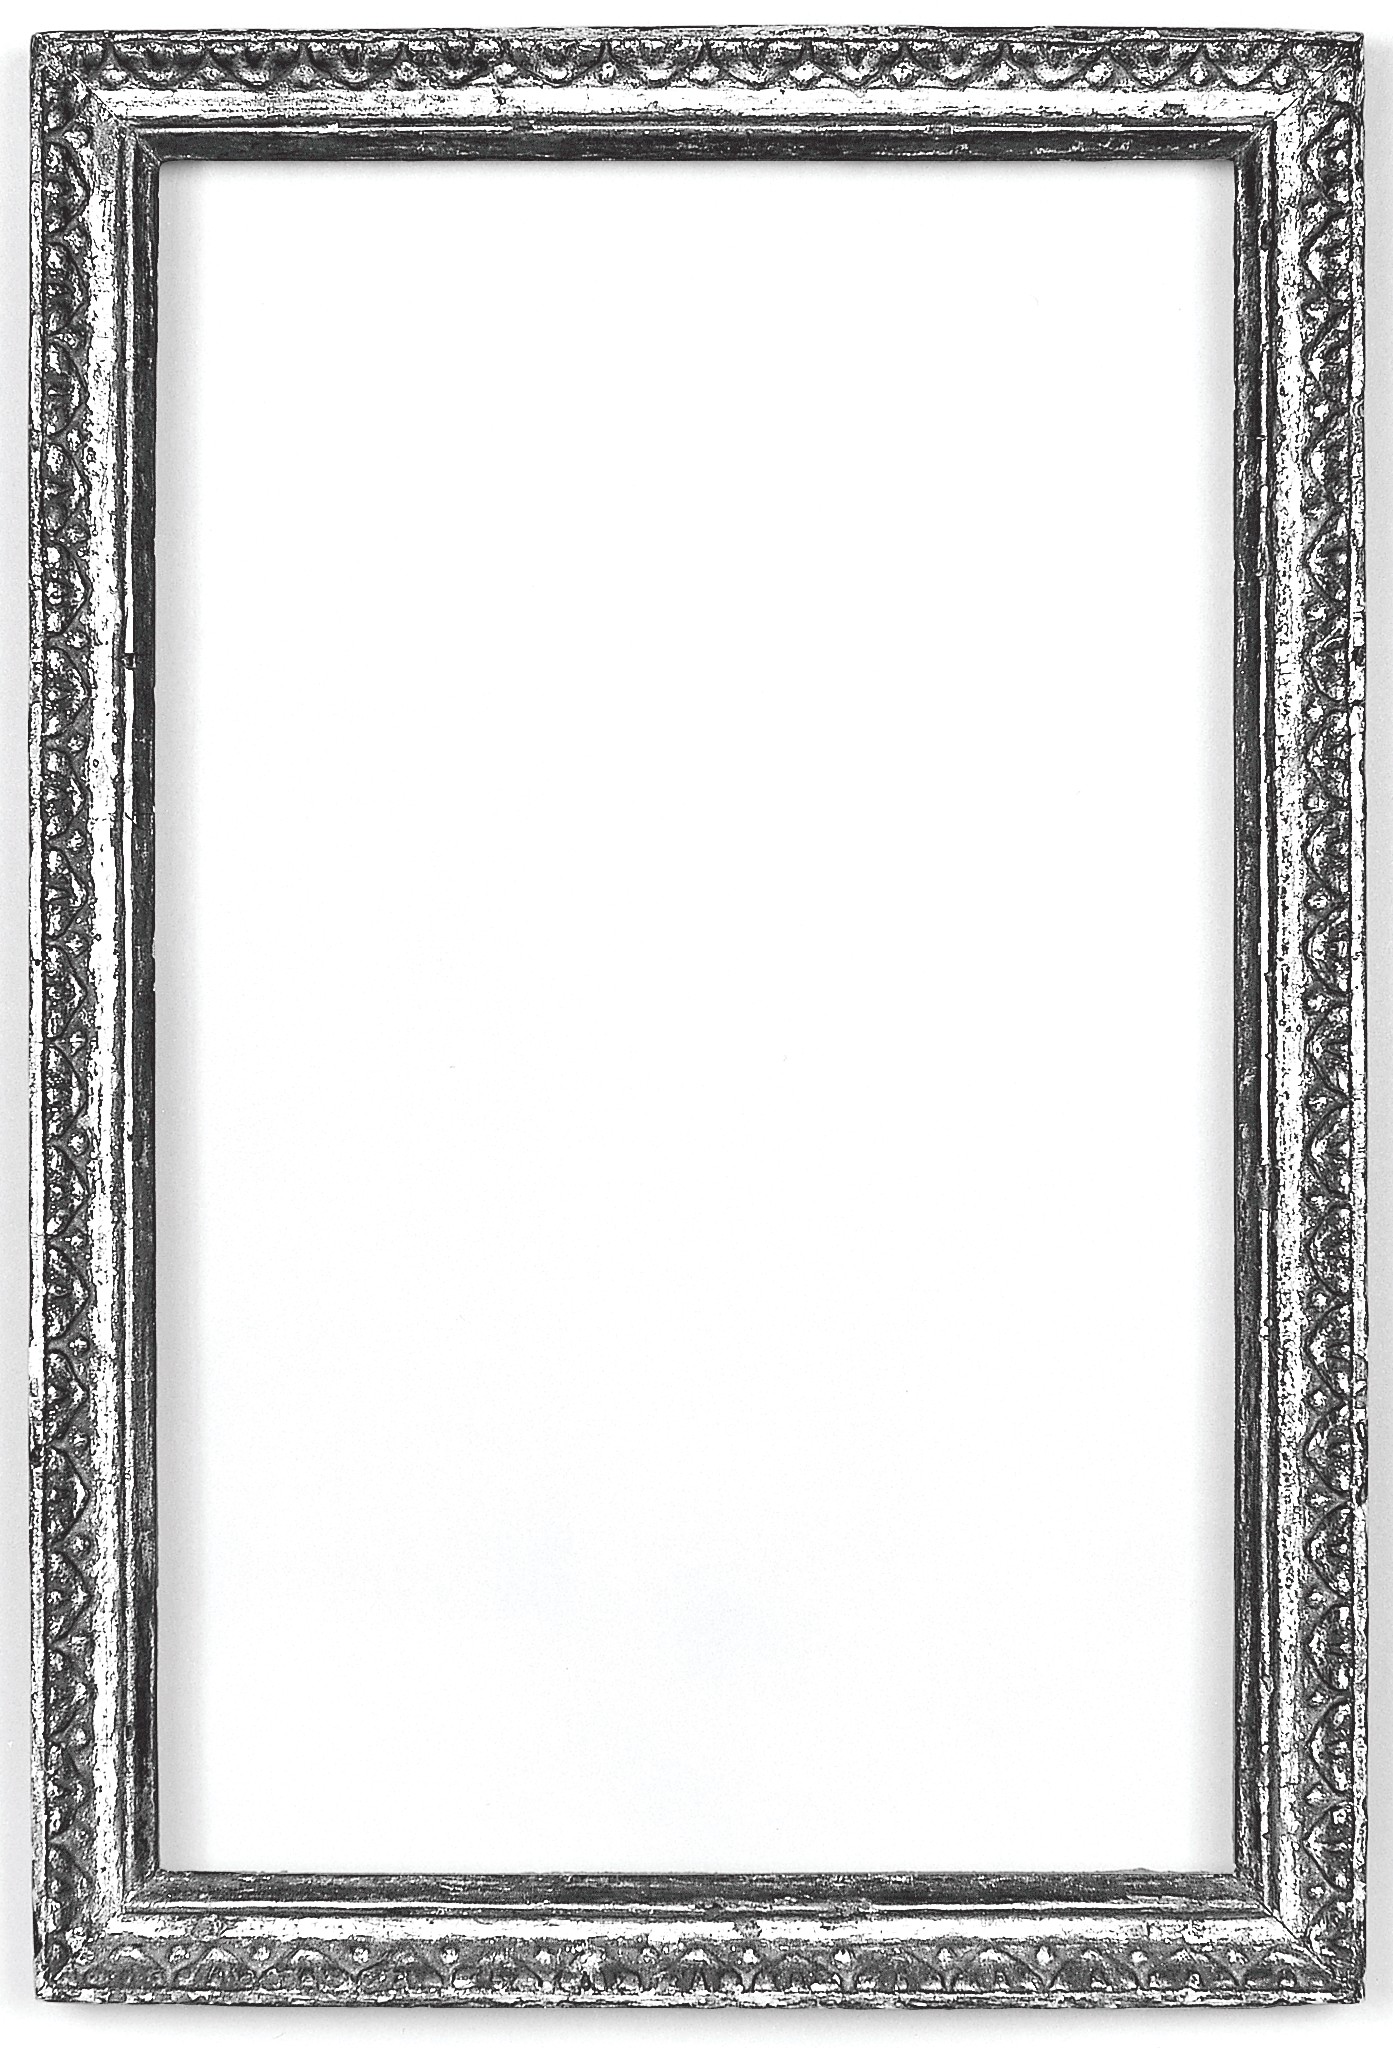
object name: frame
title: Engaged molding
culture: italian, tuscany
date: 1401-1433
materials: wood